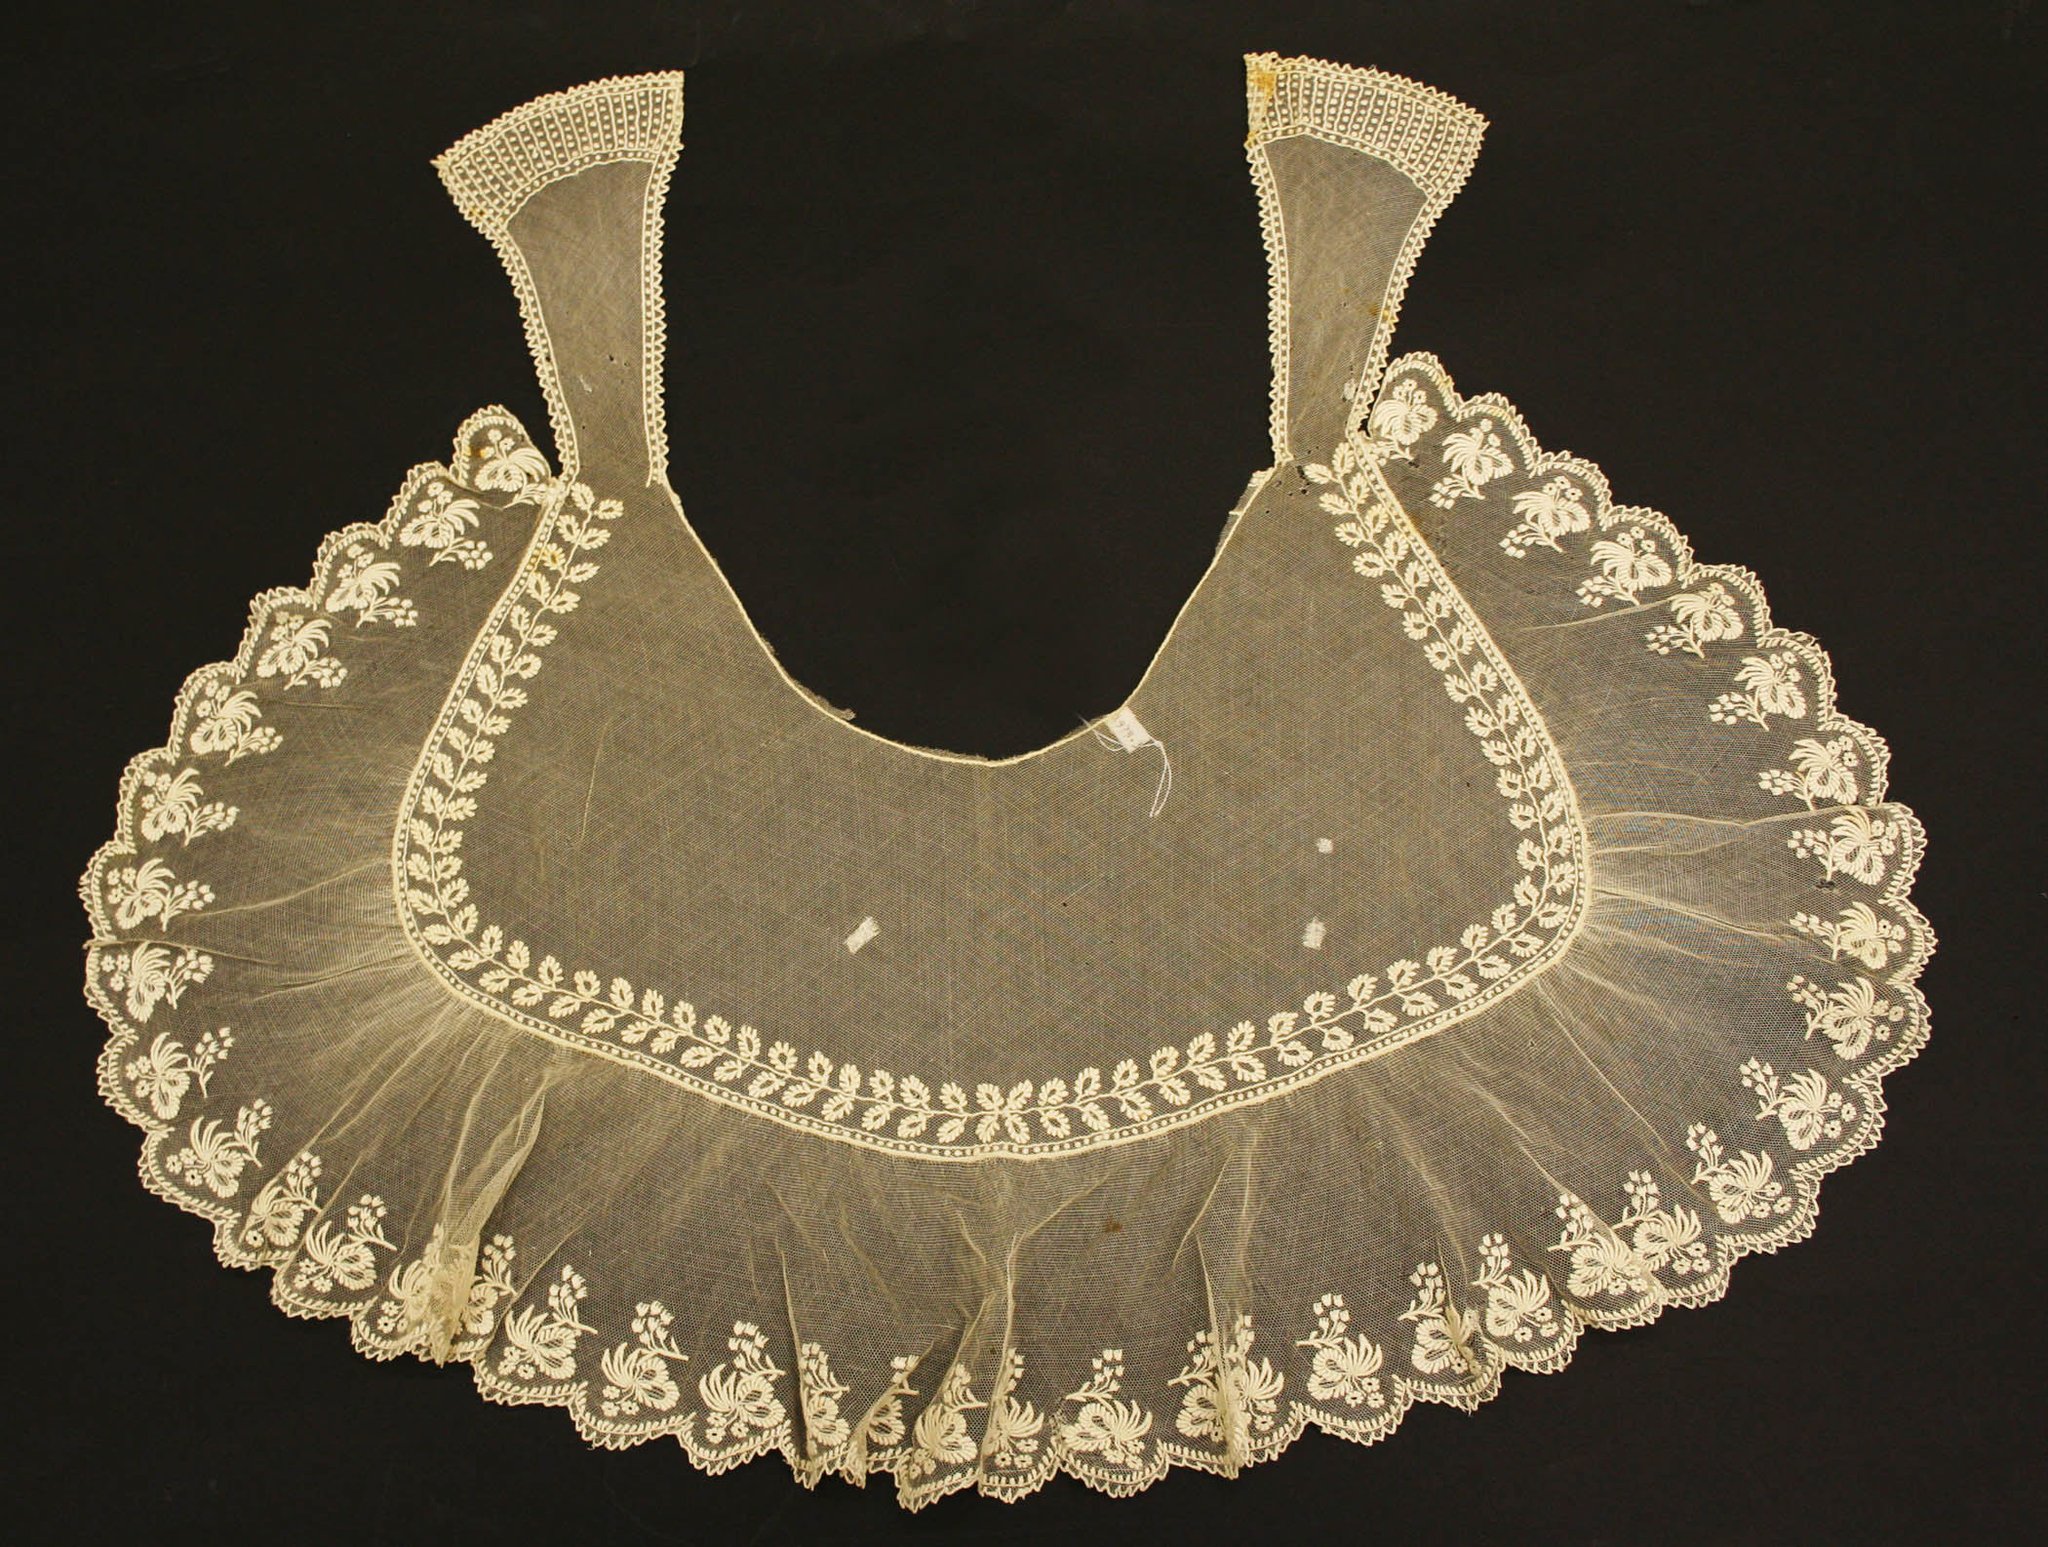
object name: collar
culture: american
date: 1830-1839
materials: cotton